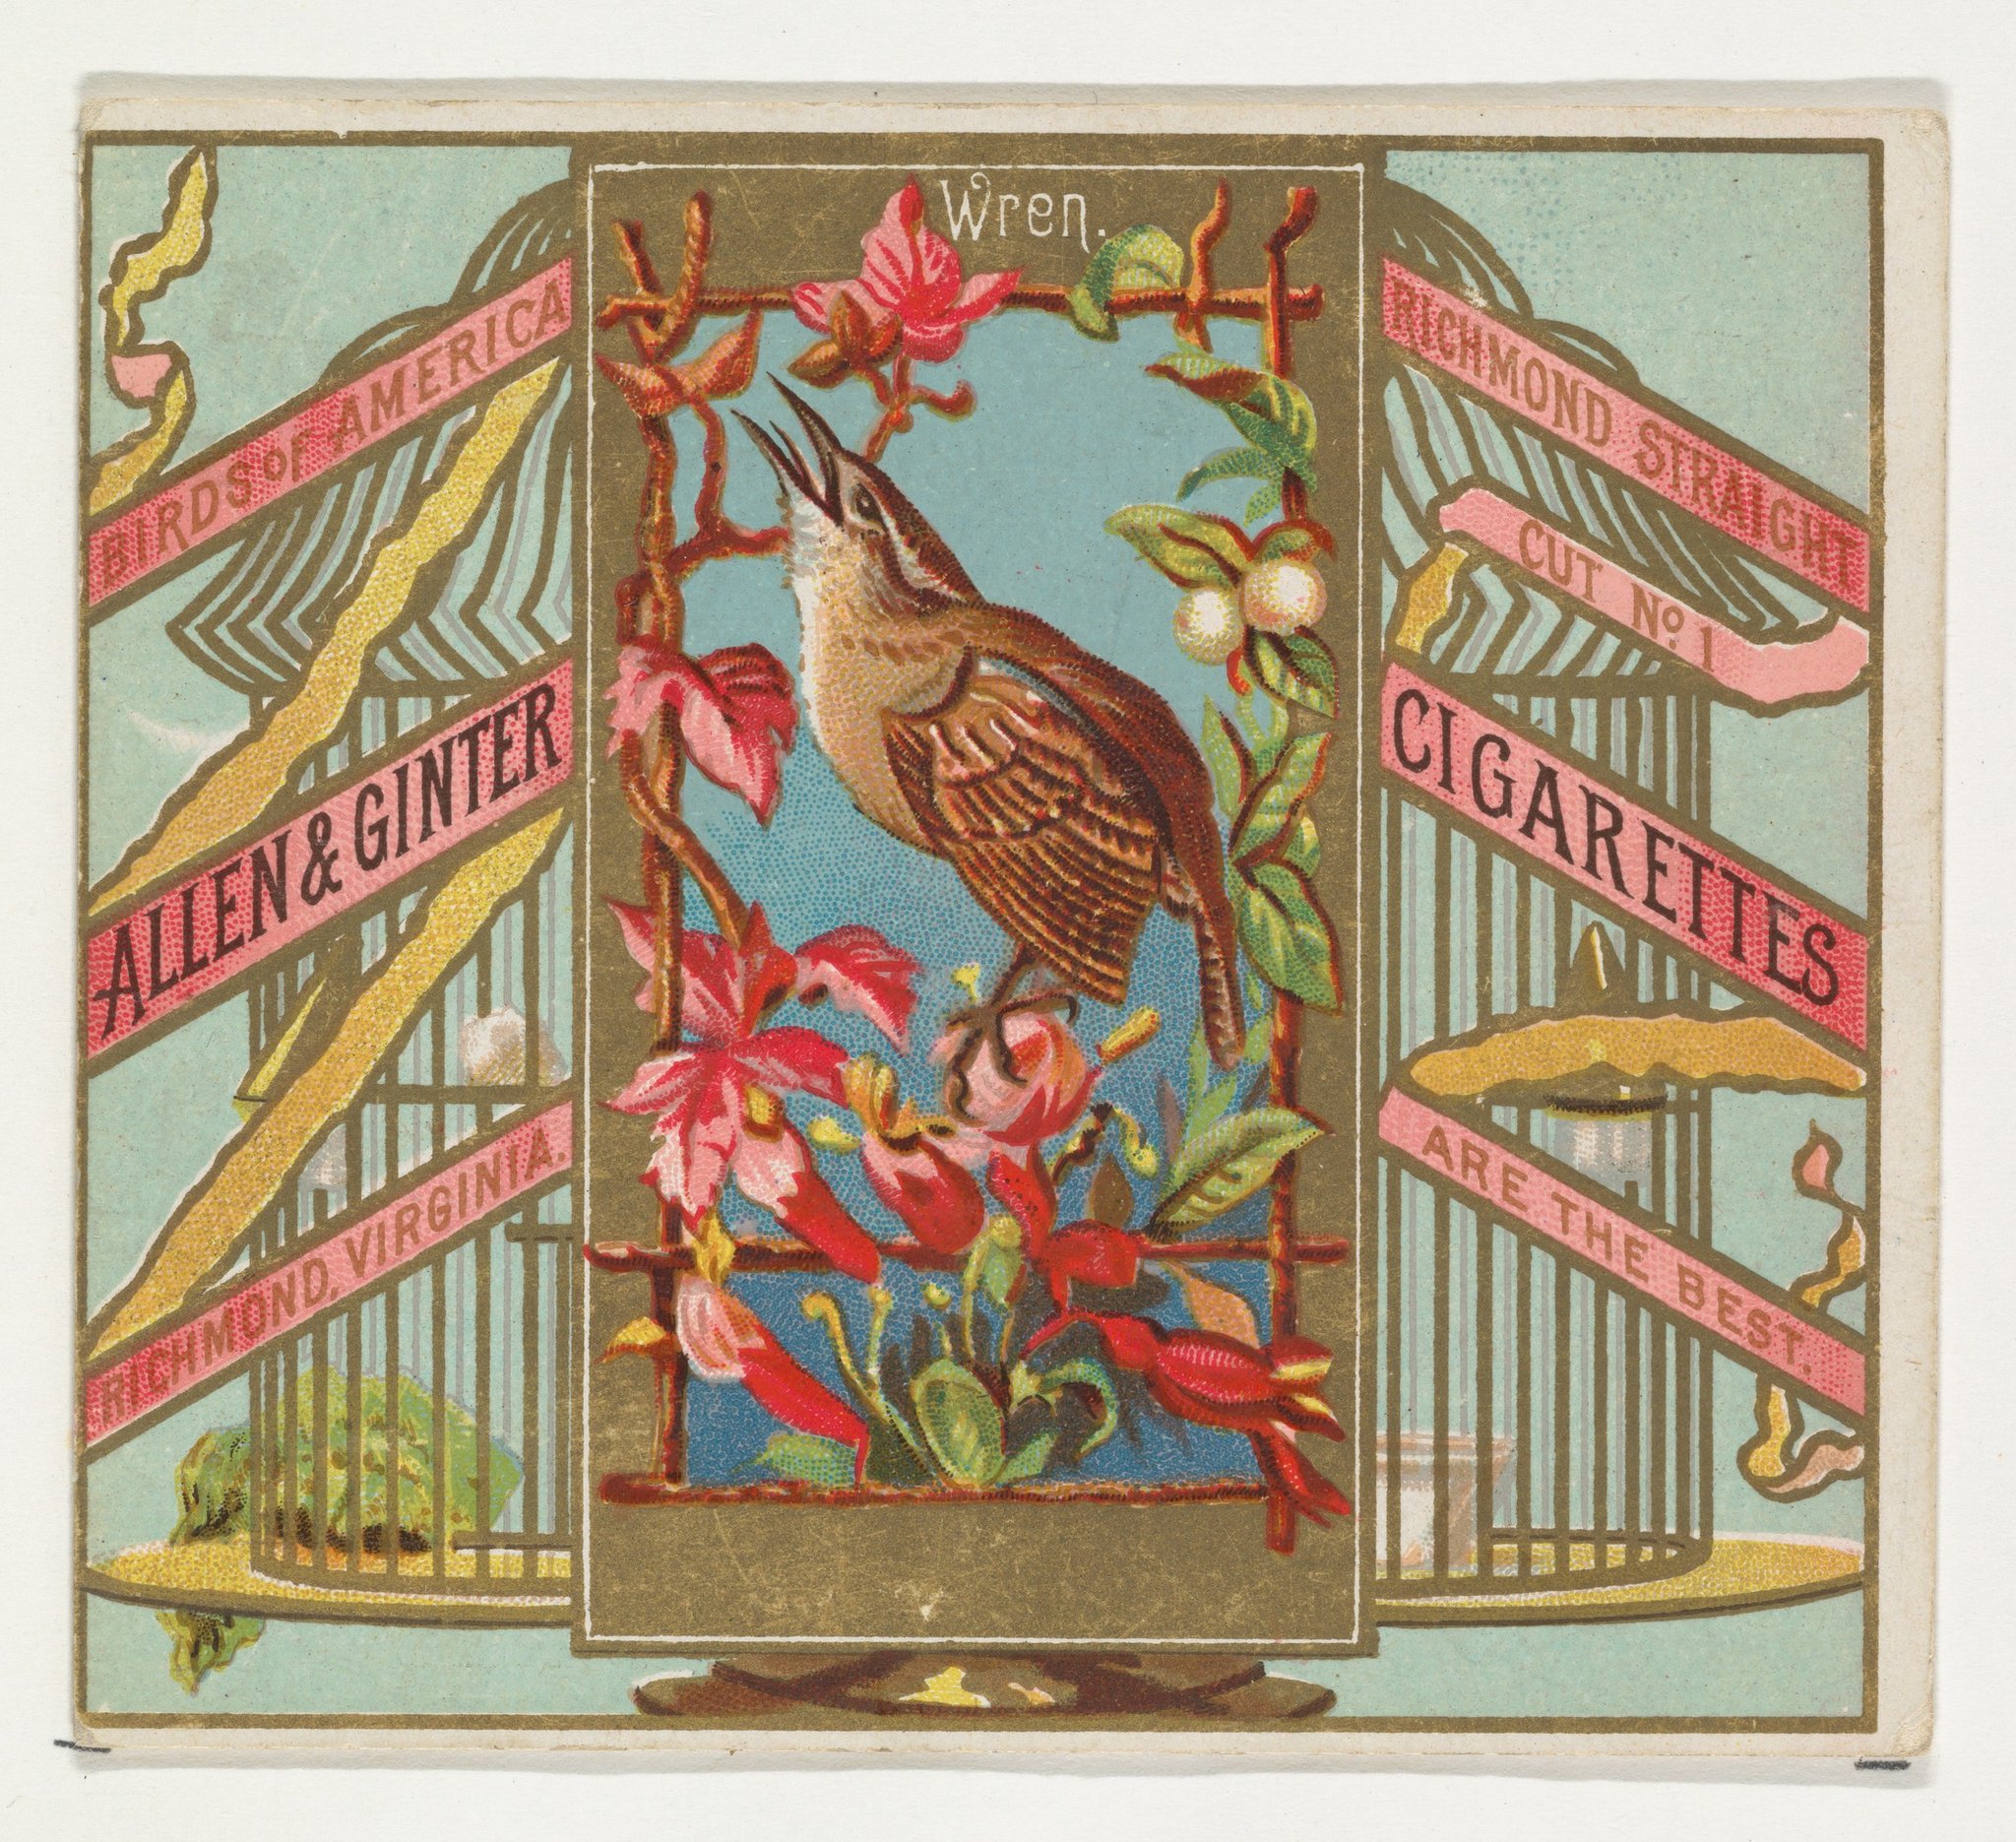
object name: print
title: Wren, from the Birds of America series (N37) for Allen & Ginter Cigarettes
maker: allen & ginter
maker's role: publisher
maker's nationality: american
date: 1888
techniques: color lithograph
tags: birds